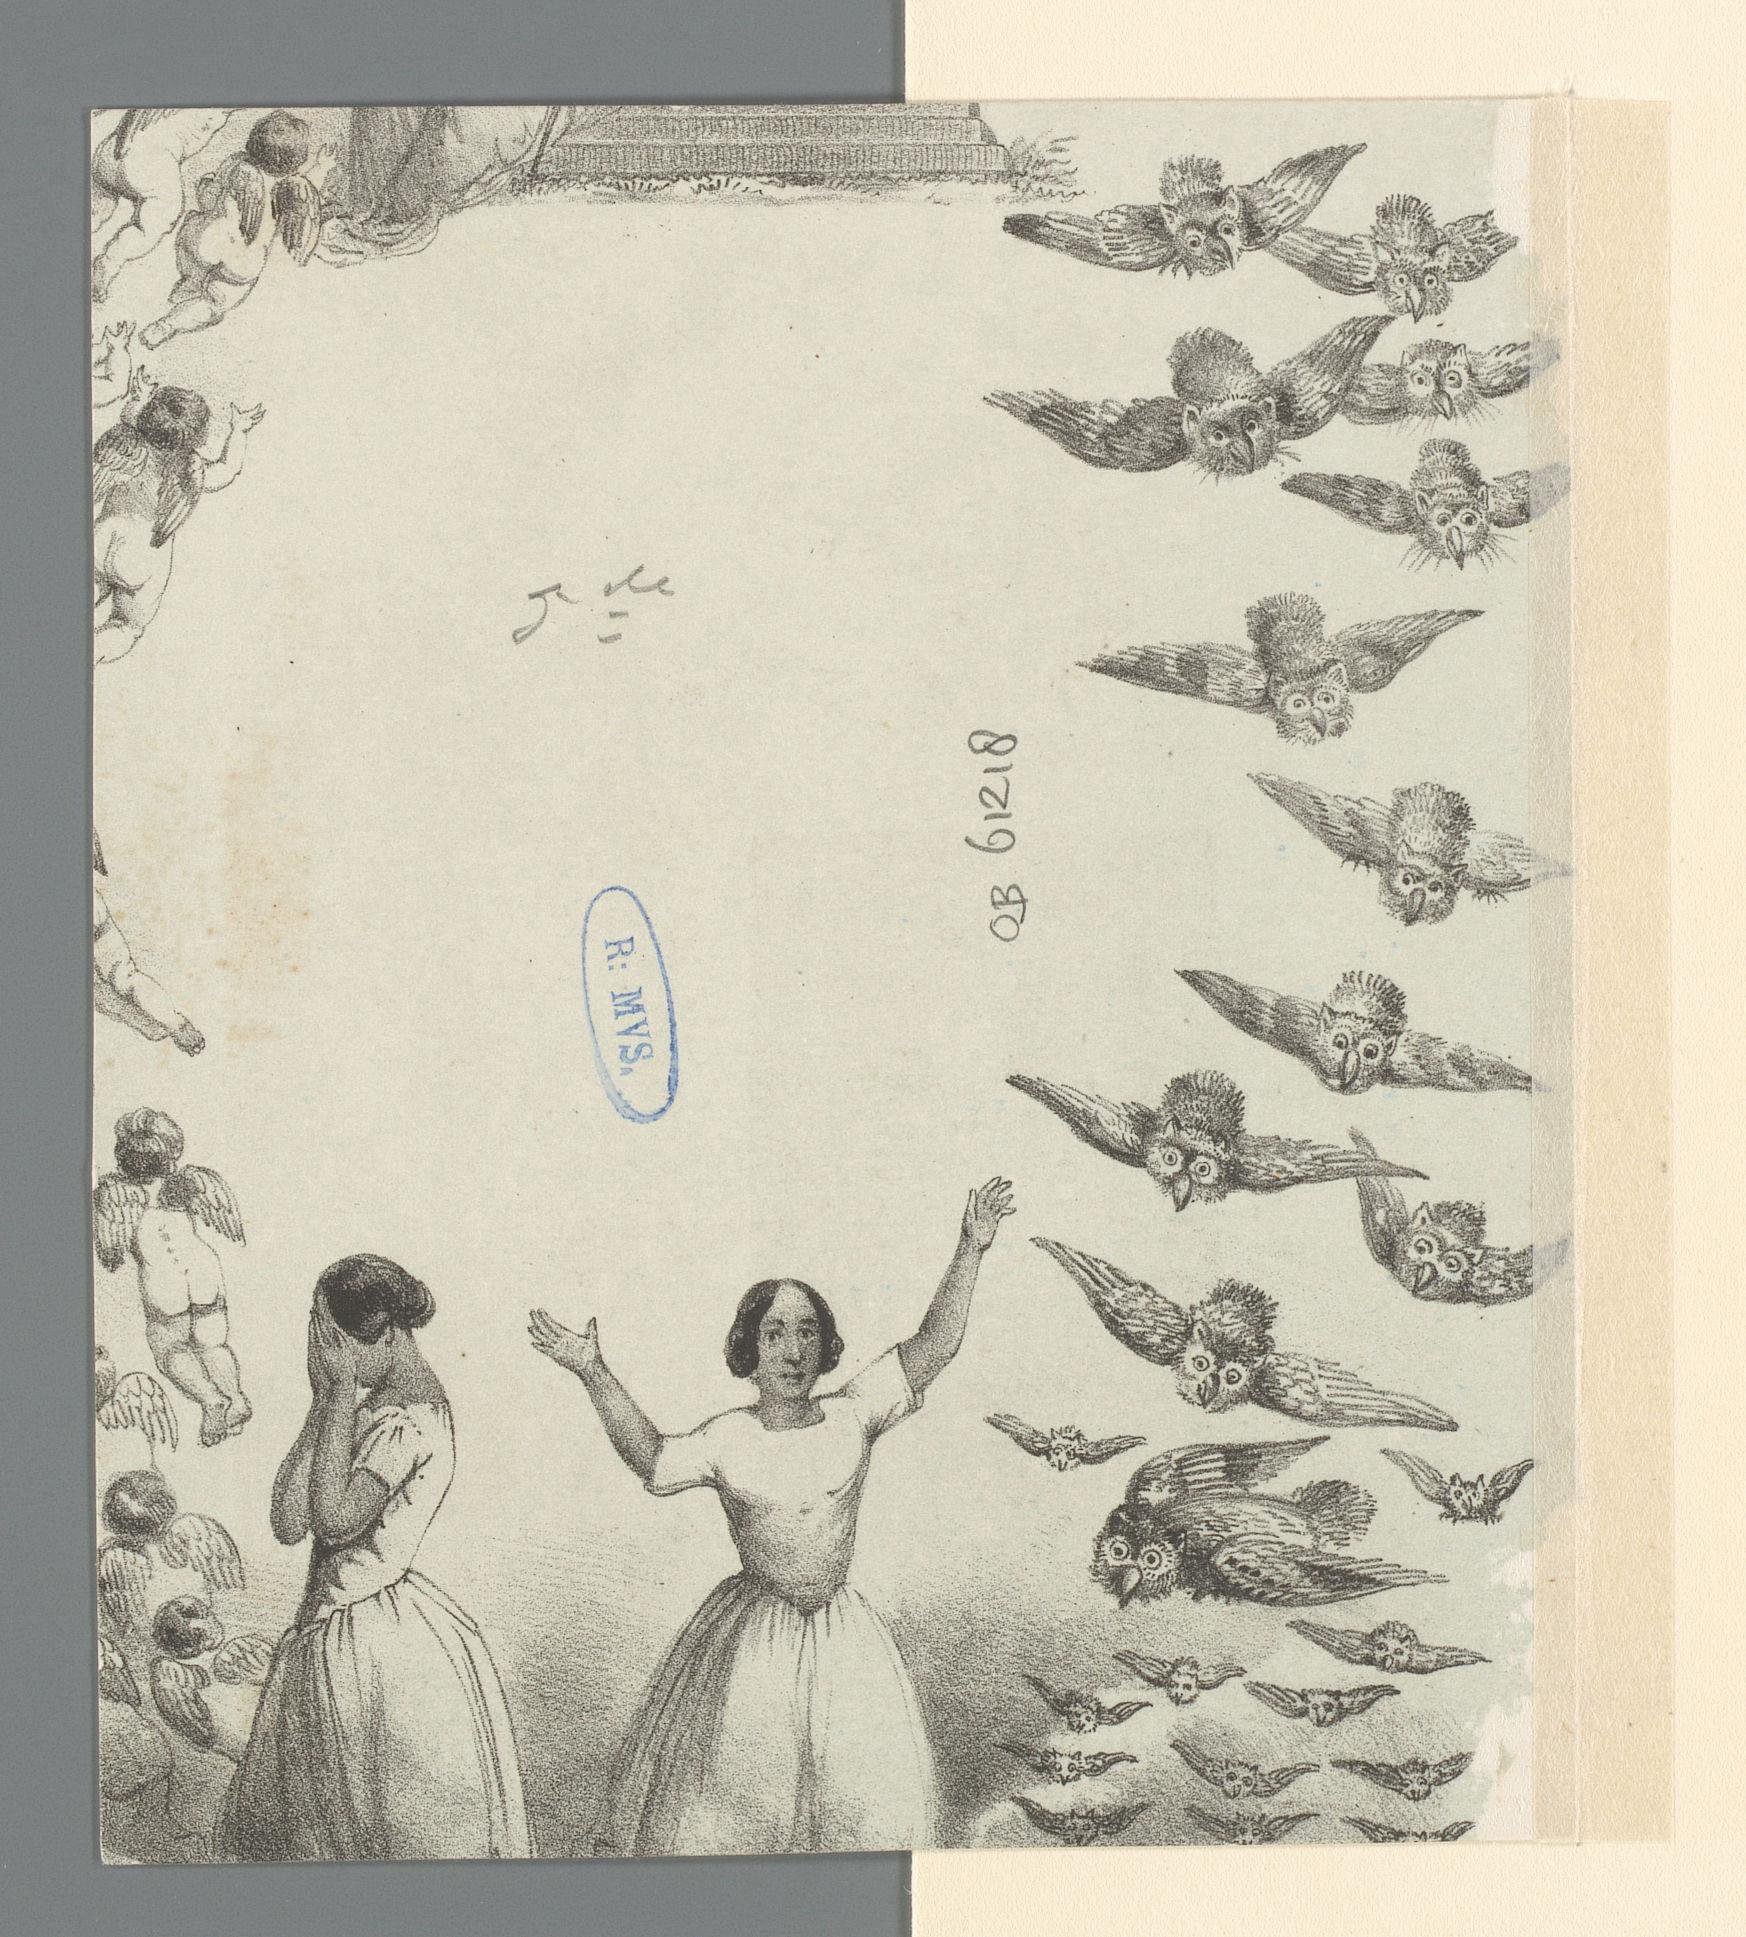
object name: print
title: Allegorie op de wijsheid met Minerva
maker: Anonymous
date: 1837-1880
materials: paper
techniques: lithograph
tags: adult woman, owls, attributes of minerva: owl, cupids: 'amores', 'amoretti', 'putti'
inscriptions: collector's mark: Lugt 2228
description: Rechts vliegen enkele uilen naar beneden, waar een vrouw met opgeheven armen staat. De identiek uitziende vrouw naast haar houdt haar handen voor haar gezicht. Voor haar vliegen enkele putti omhoog.